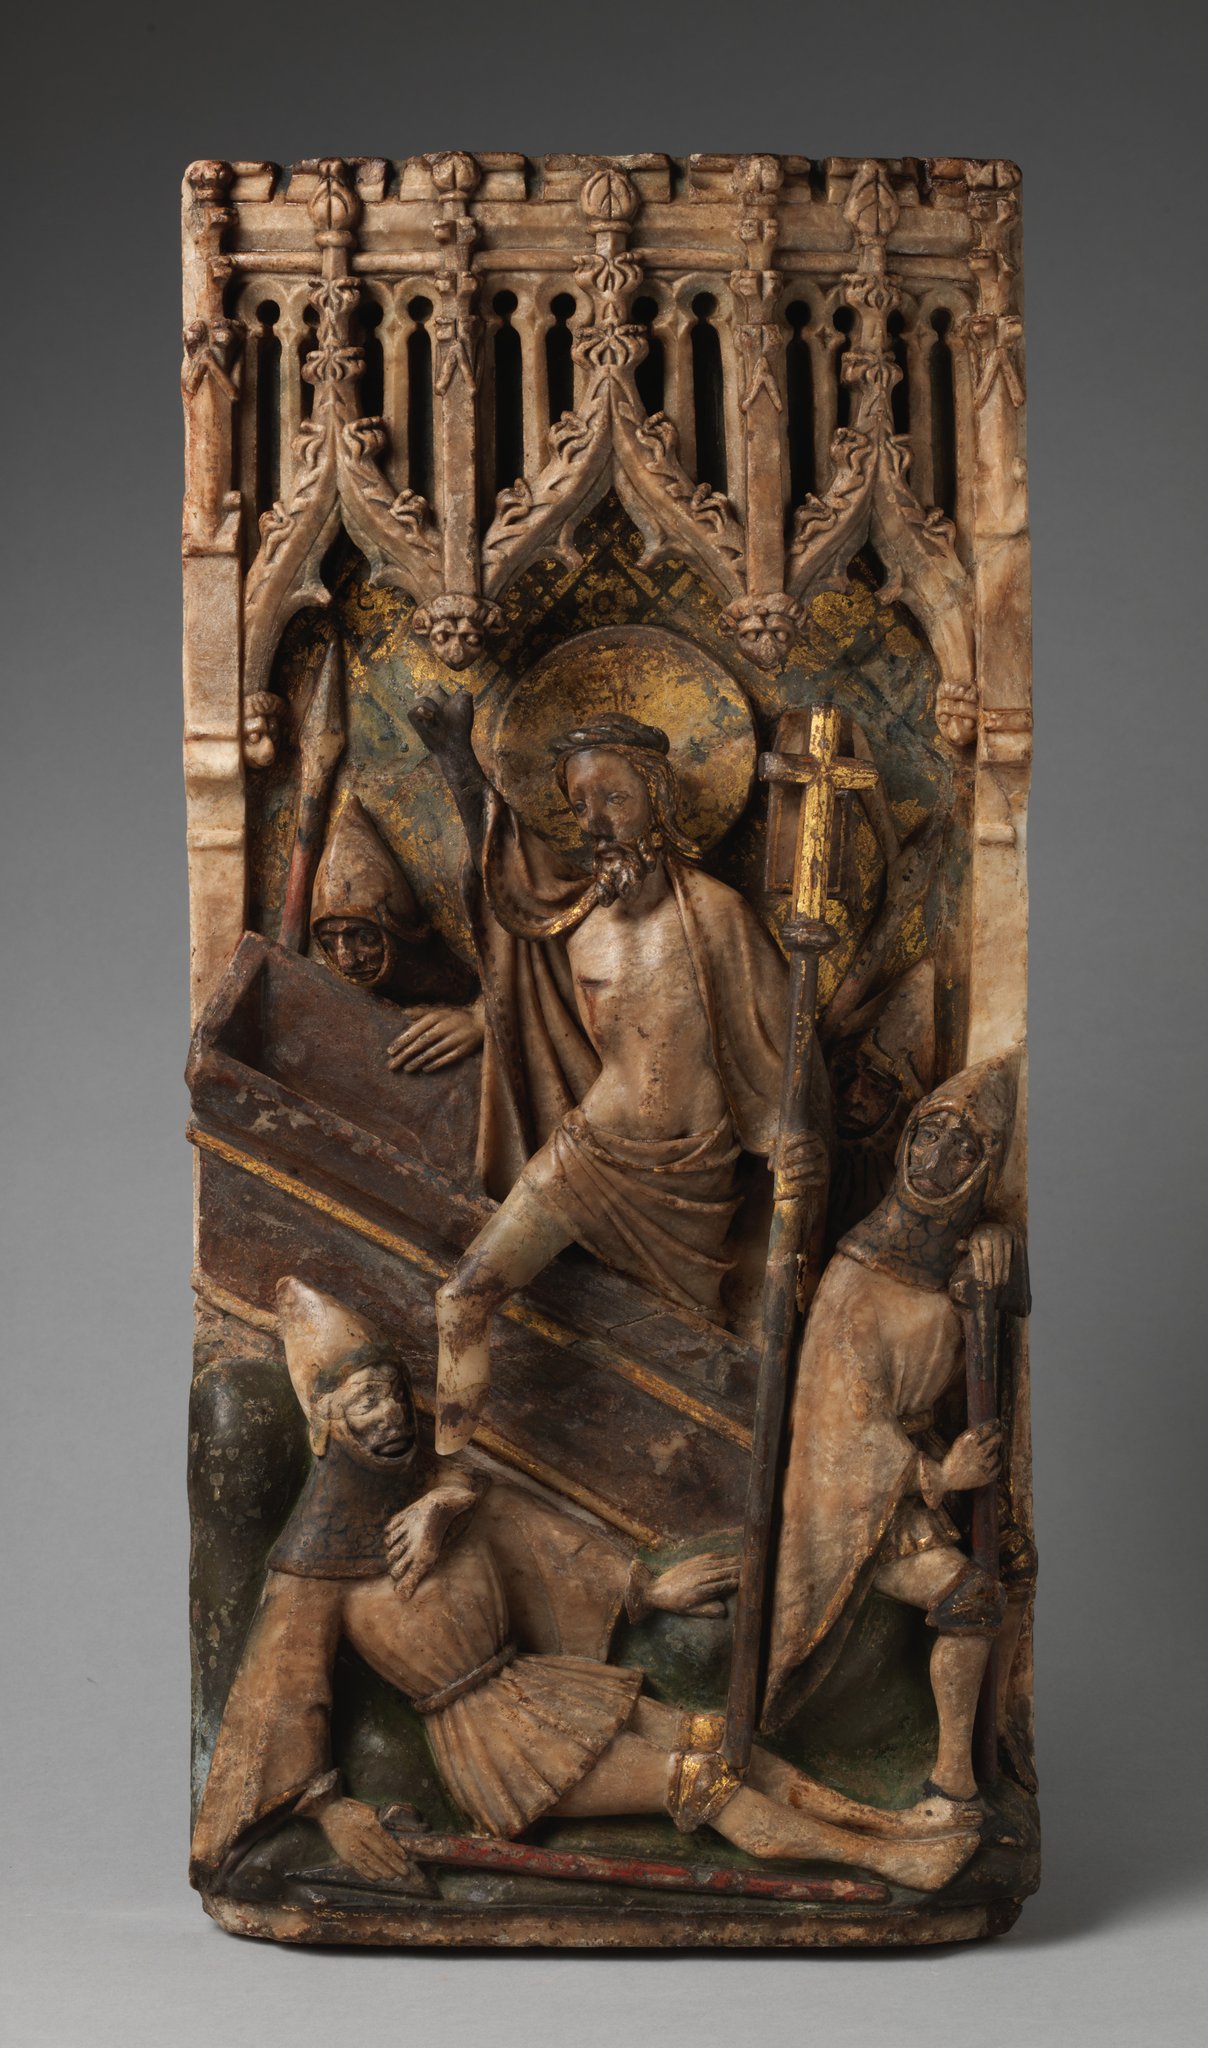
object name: relief sculpture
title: The Resurrection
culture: british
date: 1401-1500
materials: alabaster, gold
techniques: polychromy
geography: england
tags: men,christ,resurrection